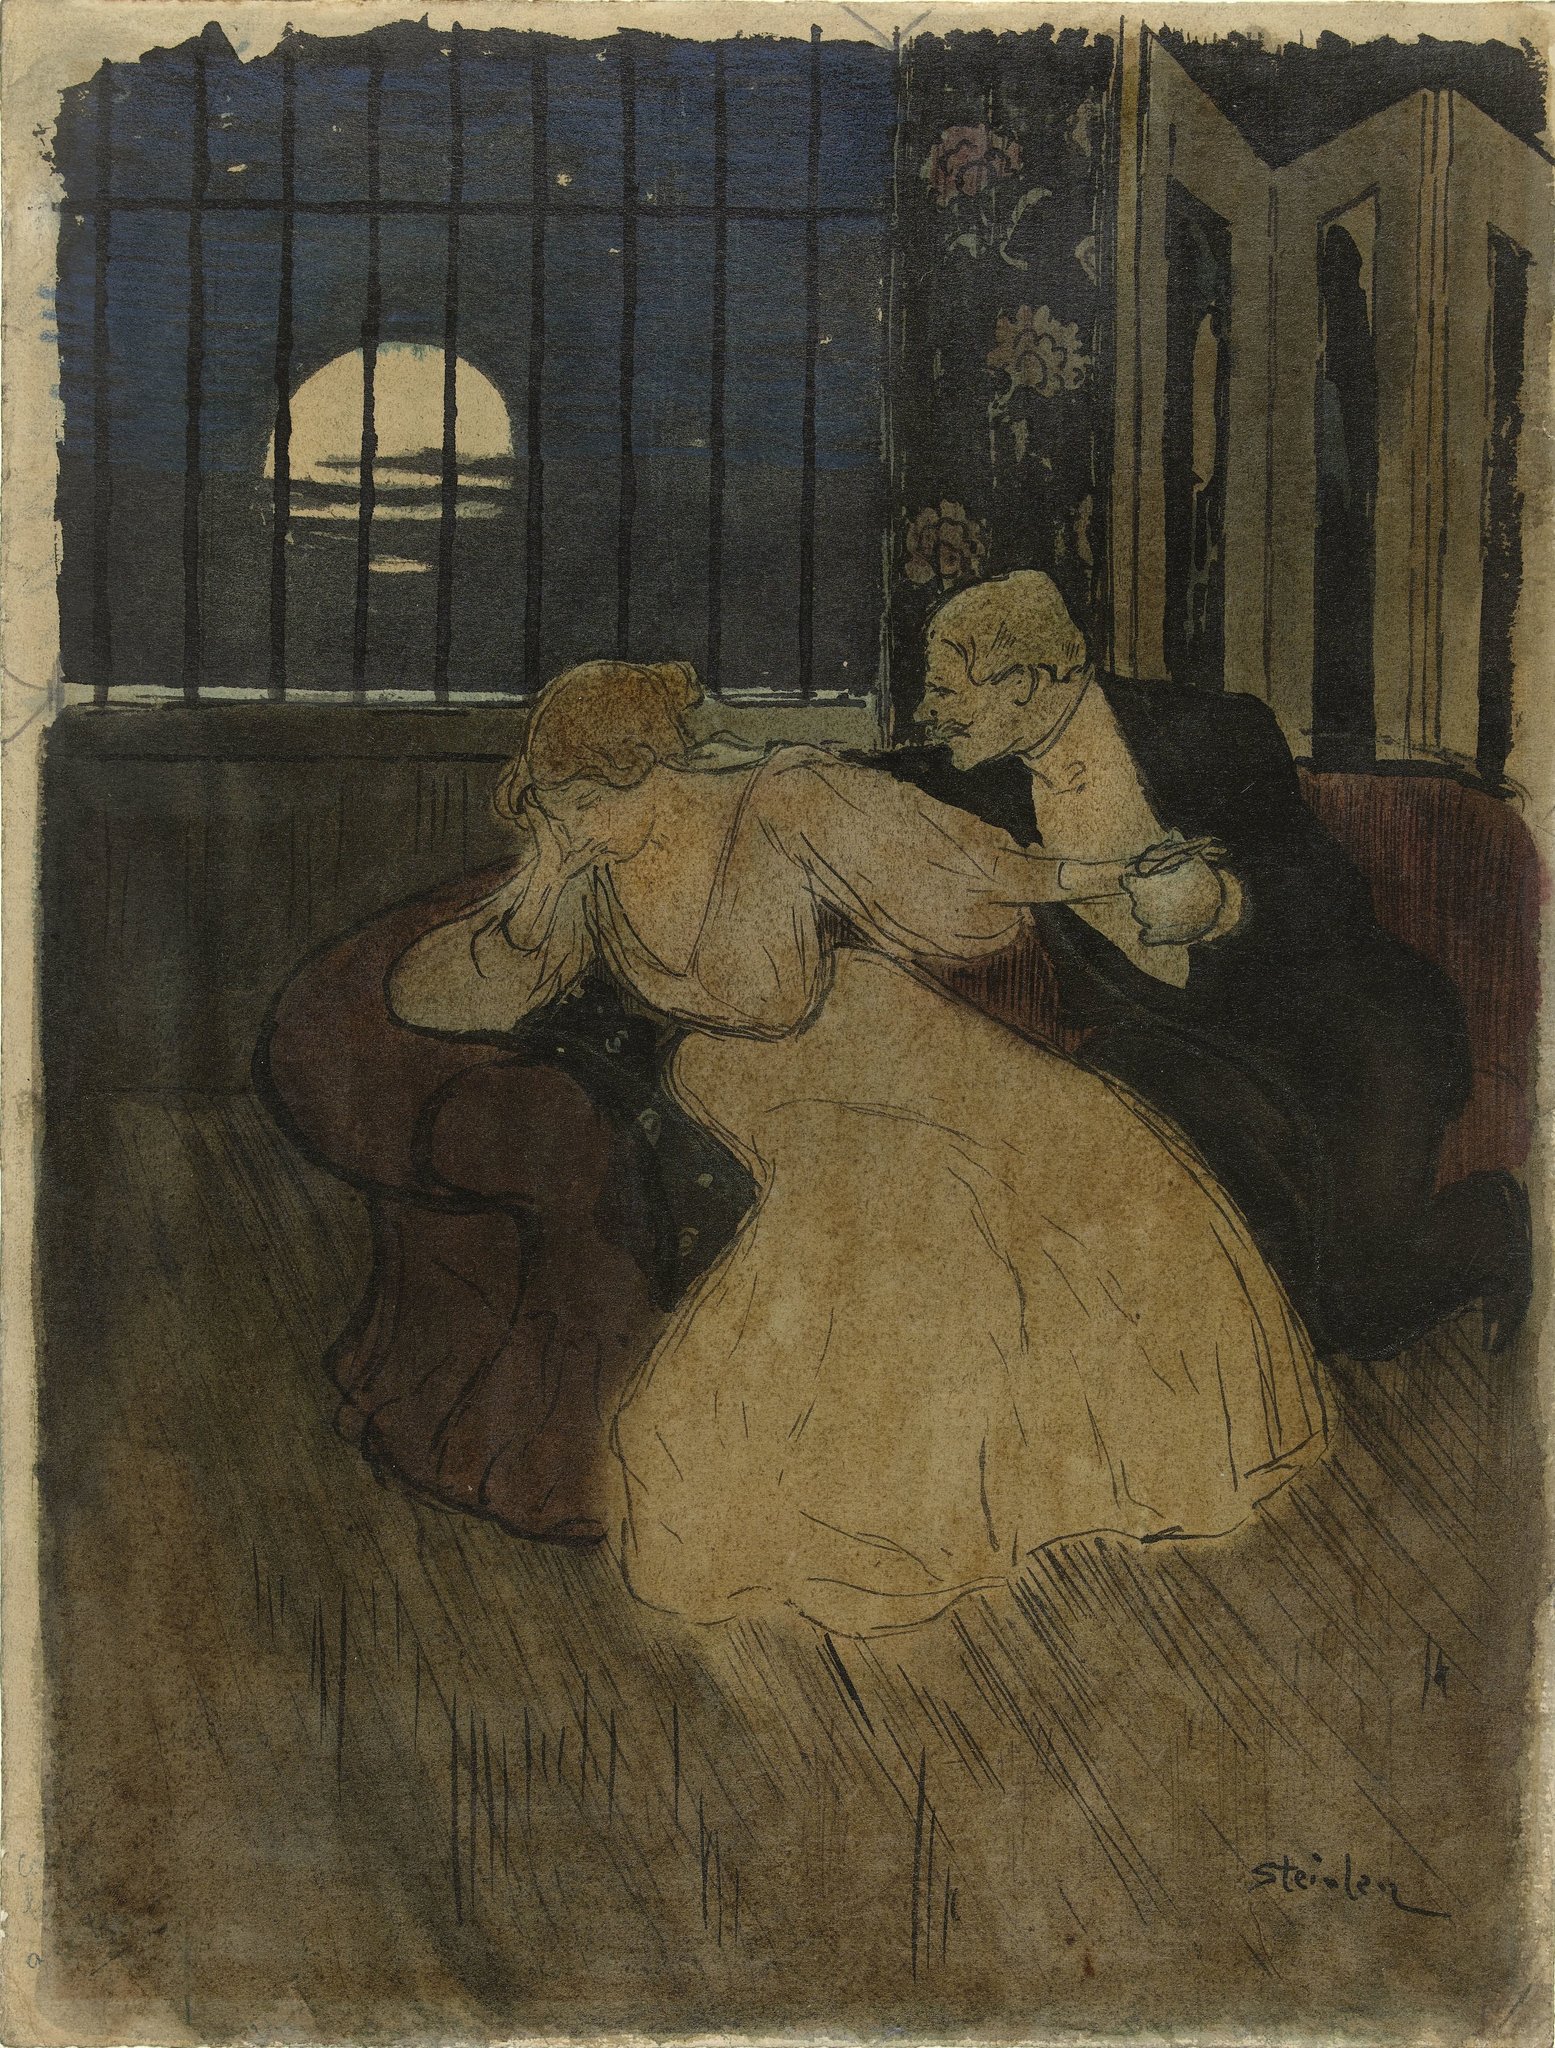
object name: drawing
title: Heer in rok tracht een twijfelende dame op een sofa te overreden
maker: théophile alexandre steinlen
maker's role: draughtsman, painter, print maker, sculptor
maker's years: 1859-1923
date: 1869-1923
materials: paper, pencil, watercolor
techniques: brush, pen, varnishing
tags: unsuccessful love affair; seduction, one-sided courting